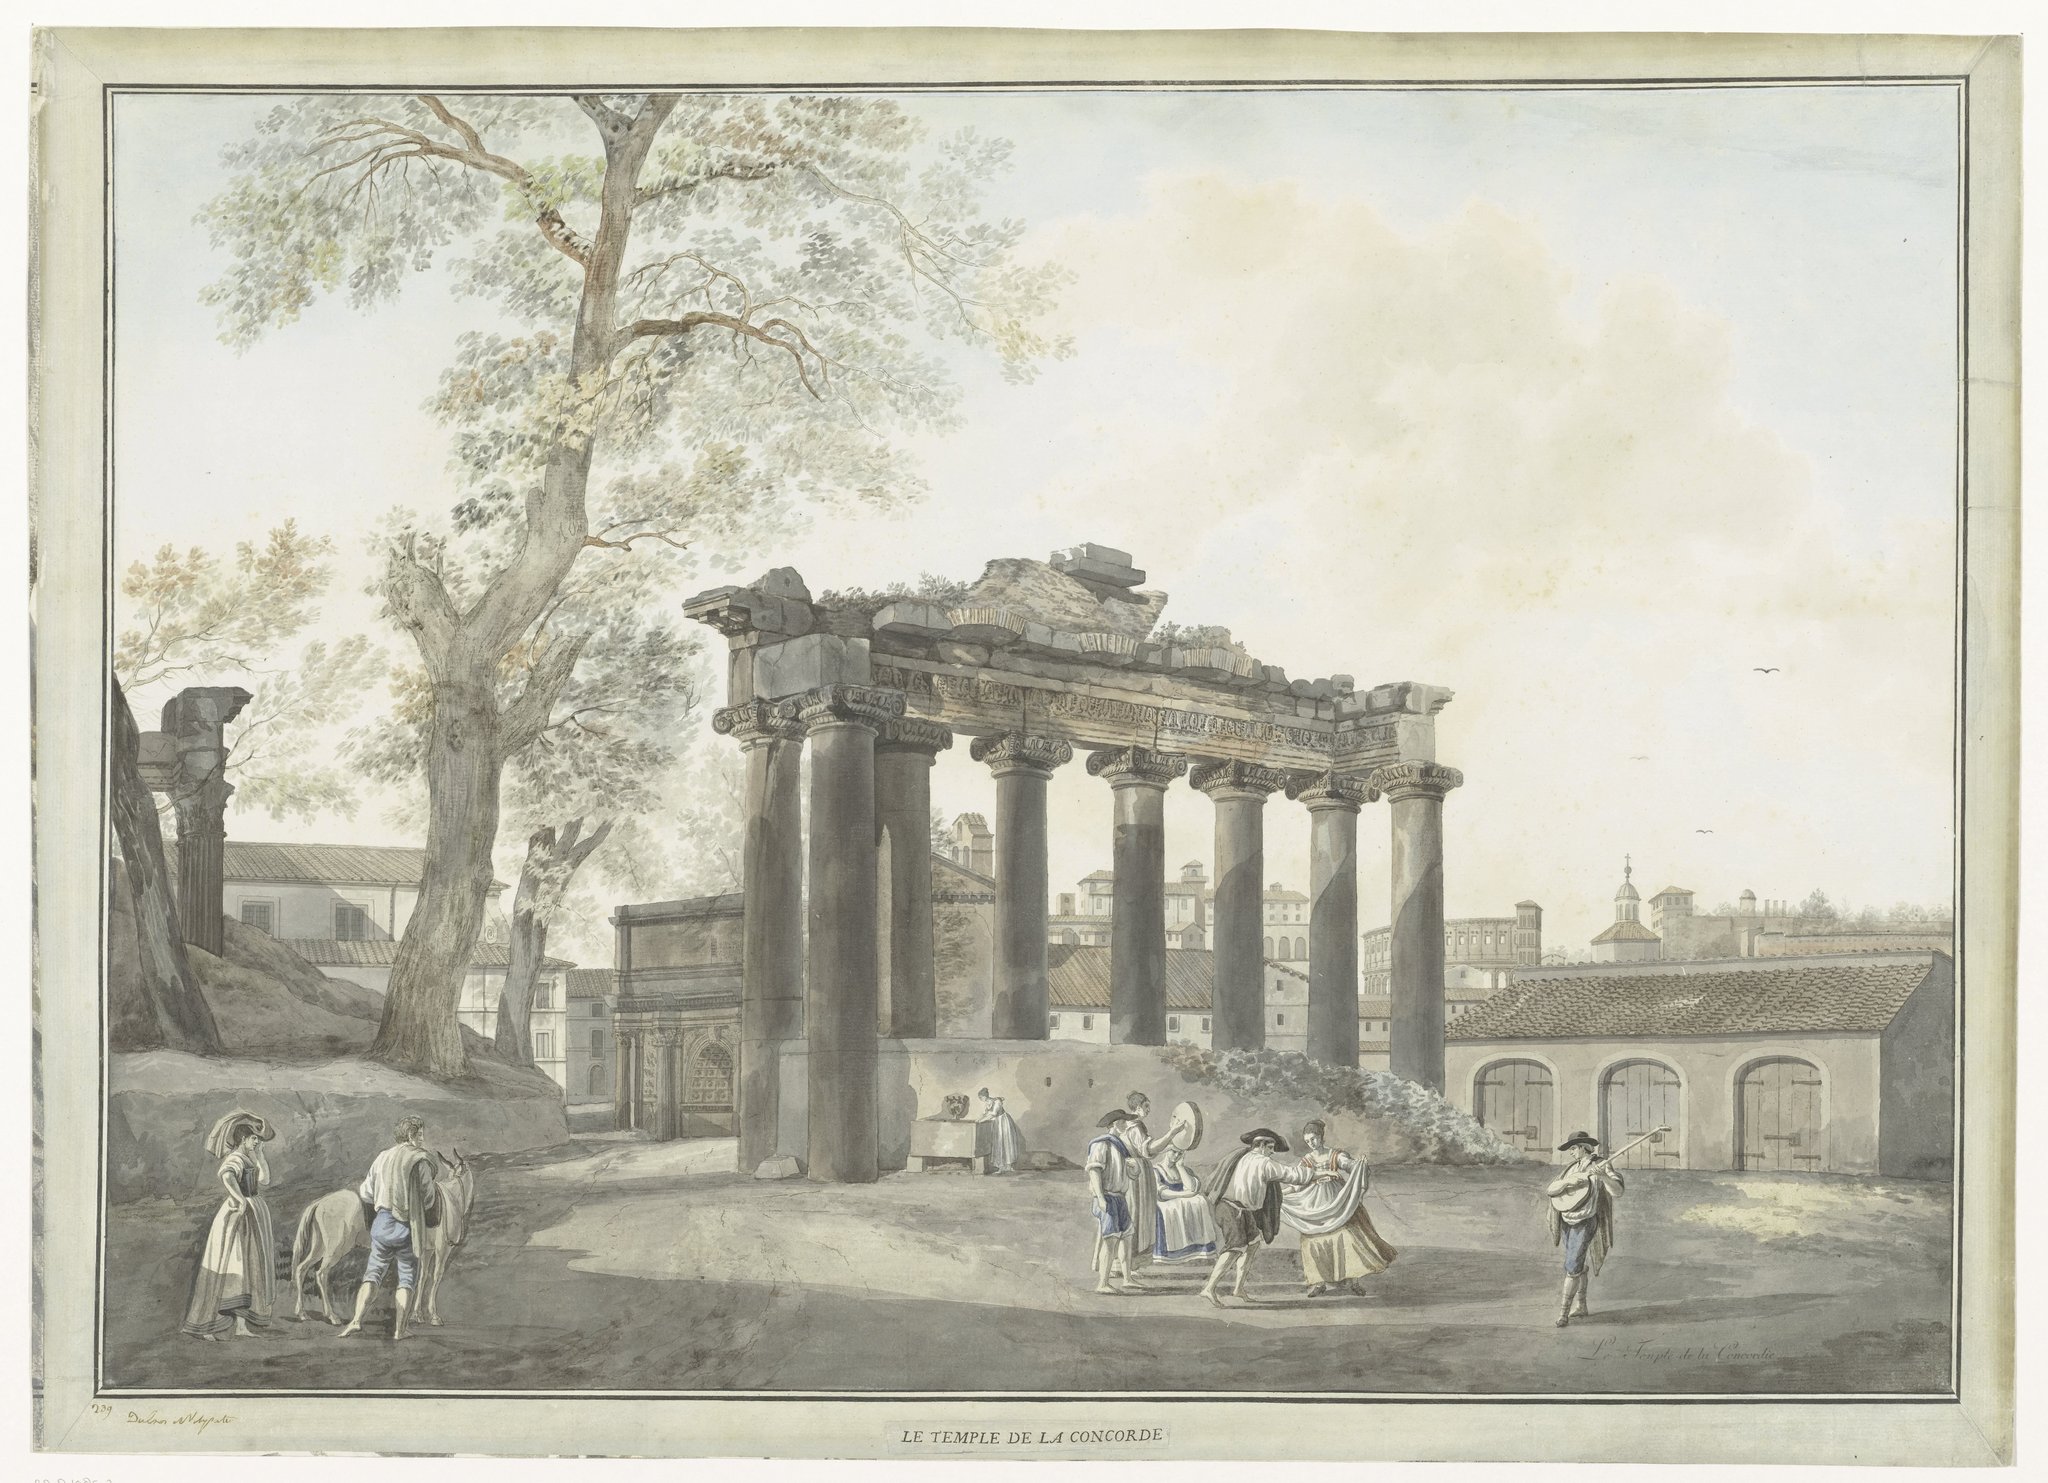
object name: print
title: Gezichten op Rome en omgeving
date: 1758-1803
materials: paper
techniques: colour, etching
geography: italy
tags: temple, shrine ~ roman religion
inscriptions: collector's mark: Lugt 2760, number: ‘239’, collector's mark: Lugt 2228, inscription: ‘Ducros Volpato’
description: Gezicht op de resten van de Tempel van Saturnus (op de prent verward met de resten van de Tempel van Concordia) op het Forum Romanum te Rome. Voor de zuilen van de tempel een groep dansende en musicerende figuren. Op de achtergrond de Boog van Septimius Severus. Titel in het Frans onder de voorstelling.